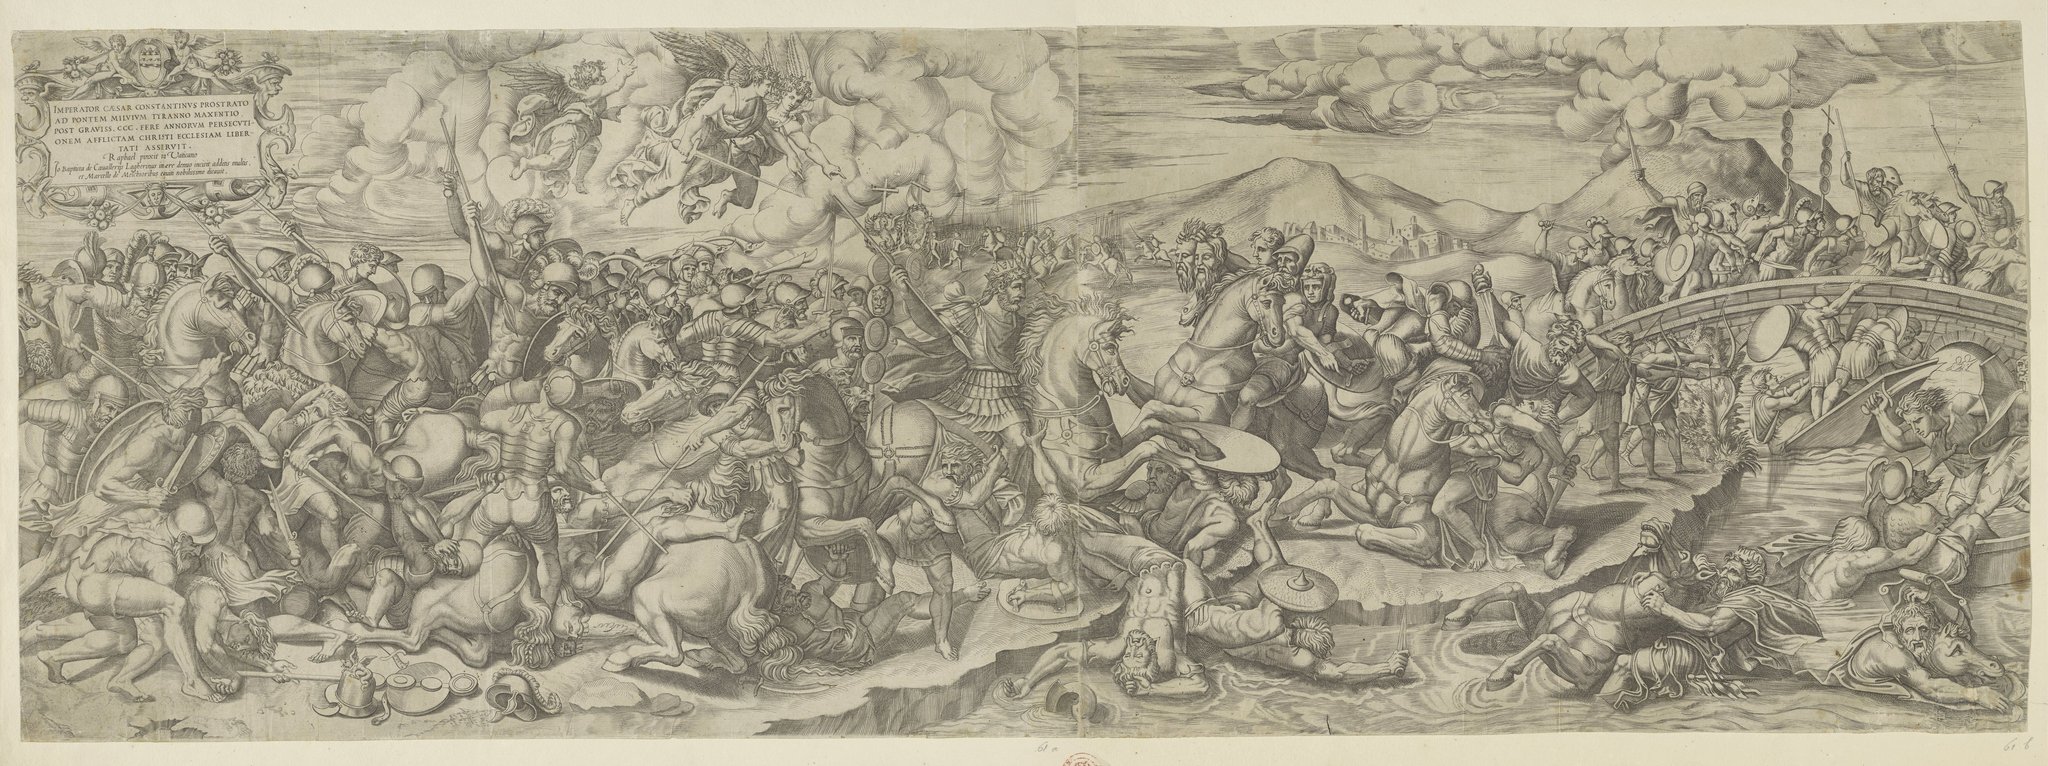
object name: print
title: Slag bij de Milvische brug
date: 1535-1601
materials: paper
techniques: engraving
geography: italy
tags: the battle of the milvian bridge (saxa rubra): st. constantine on horseback confronts maxentius; a cross appears in the sky with in fiery letters 'in hoc signo vinces' (the raised standards of the roman soldiers carry a cross or the chi-rho monogram), warfare; military affairs (+ cavalry, horsemen), the soldier; the soldier's life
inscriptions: collector's mark: Lugt 240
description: Gevechtsscène in een landschap: slag bij de Milvische brug. De soldaten van Constantijn in gevecht met de soldaten van Maxentius. Dode lichamen liggen op de grond. Soldaten te paard verdrinken in de rivier.